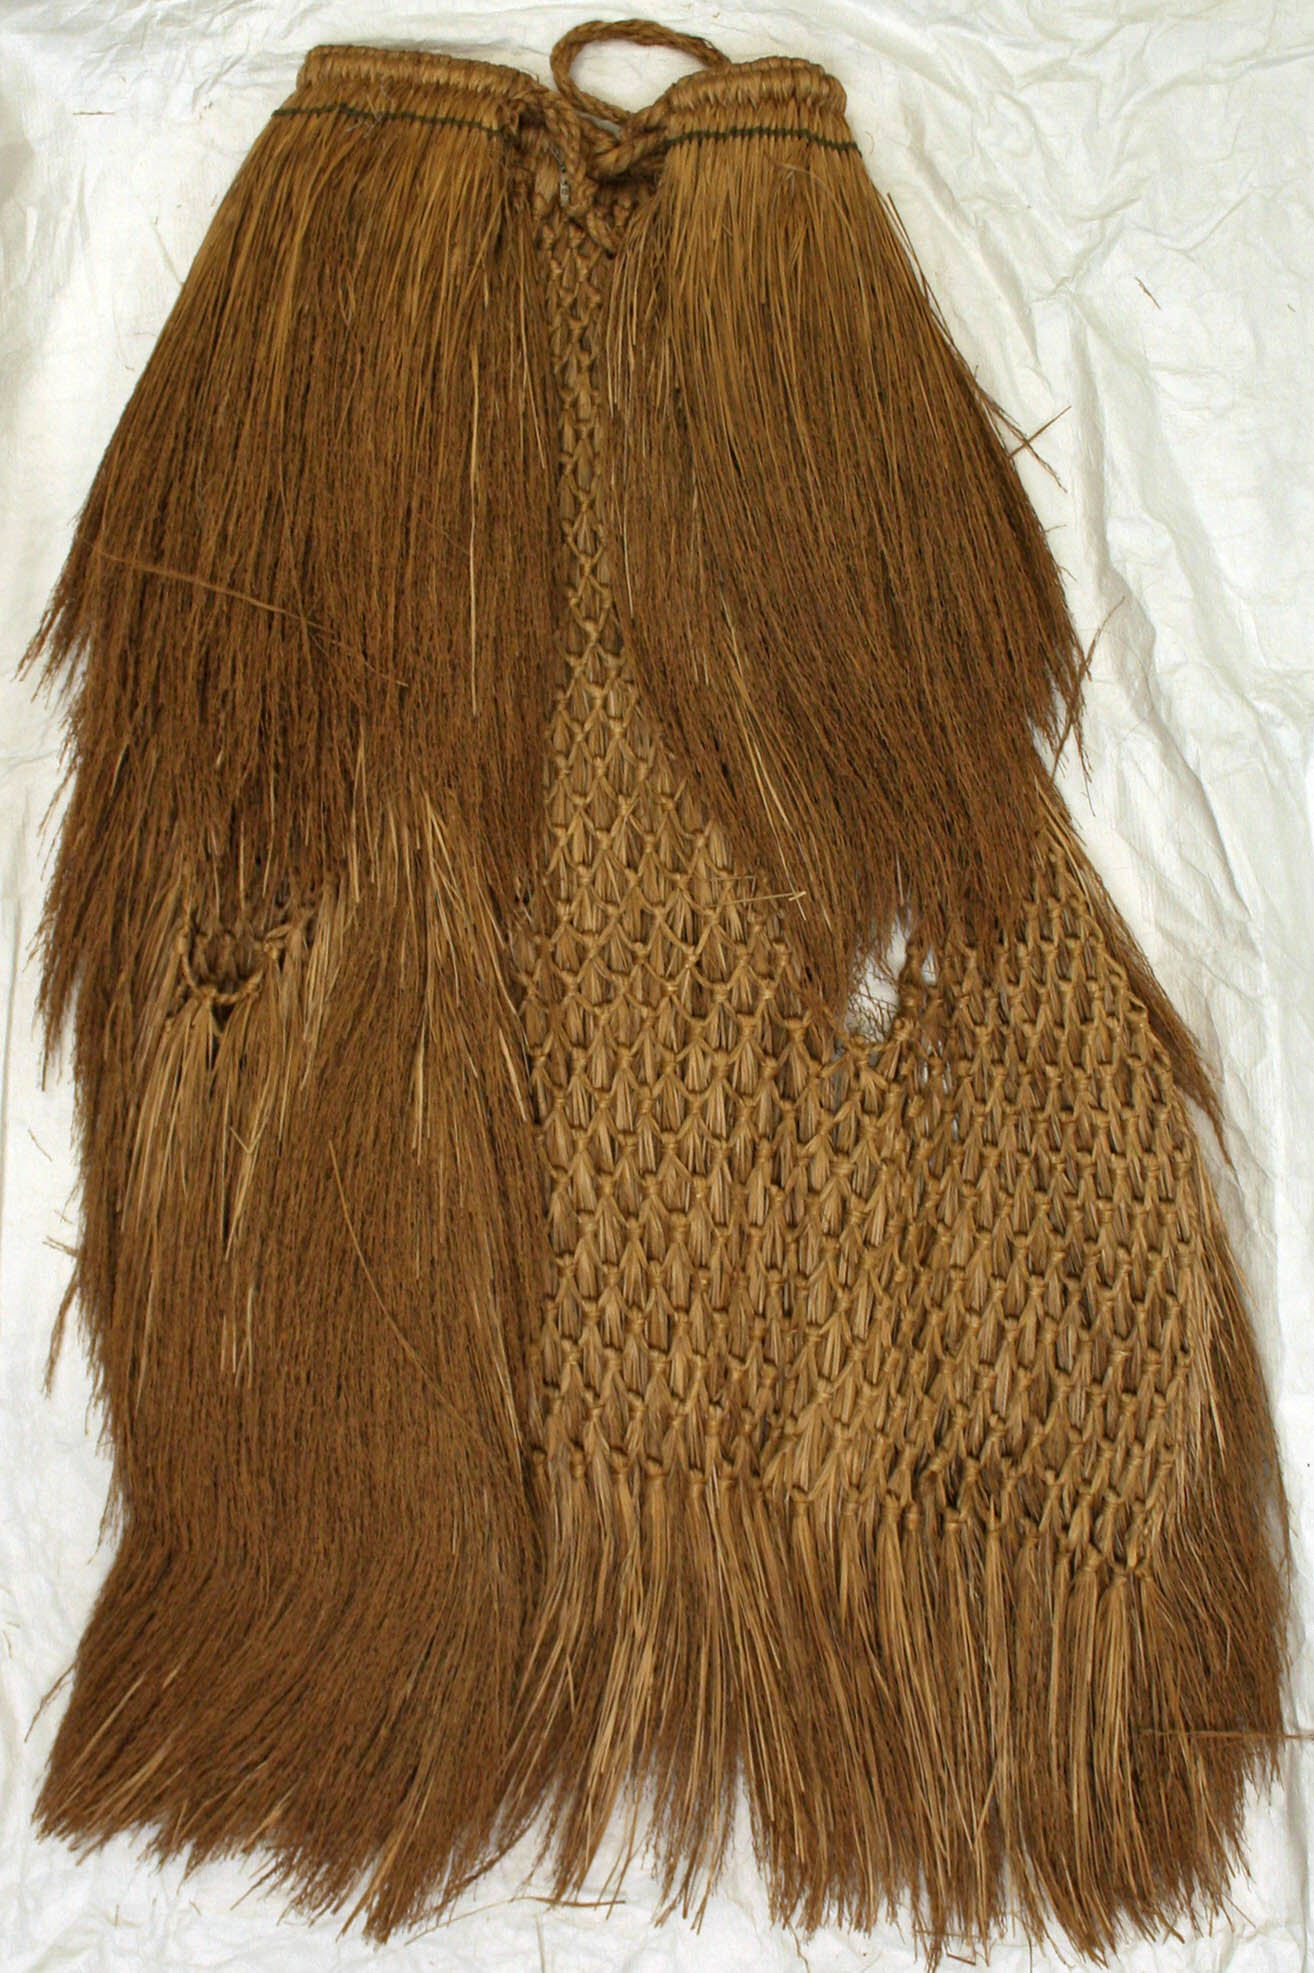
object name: raincoat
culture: japanese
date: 1800-1941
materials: fiber